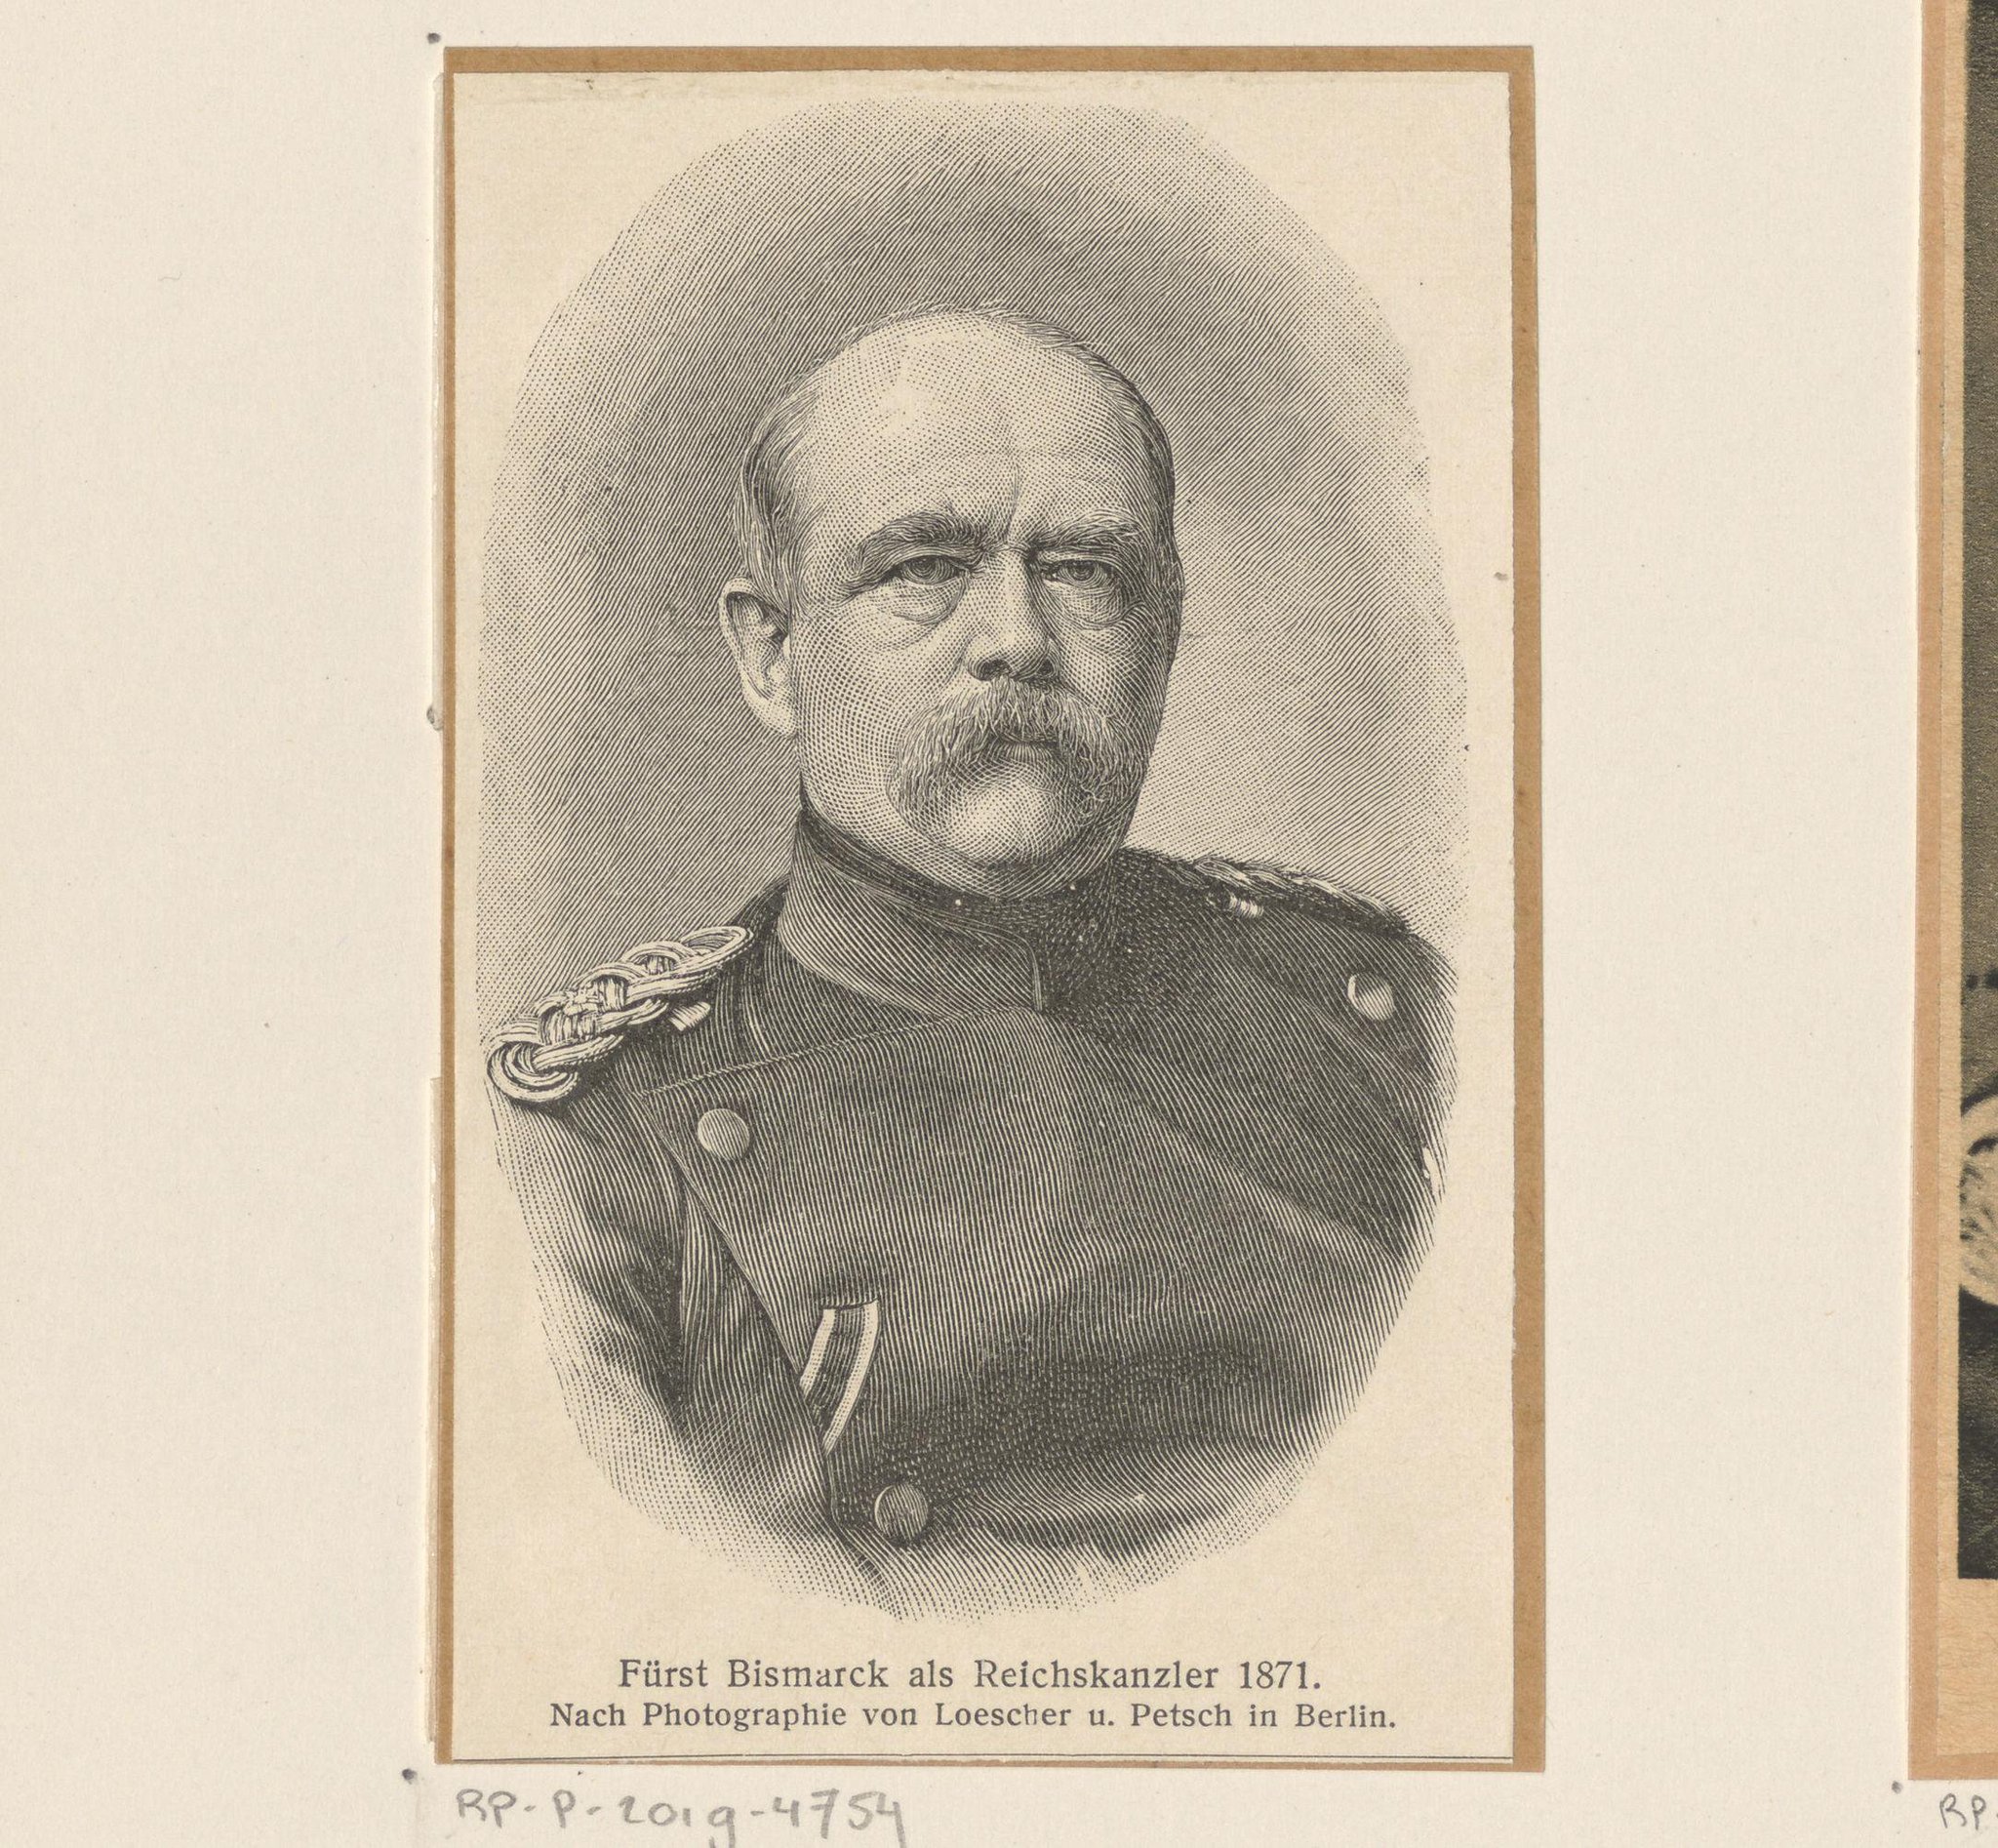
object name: book illustration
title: Portret van Otto von Bismarck op 56-jarige leeftijd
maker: Anonymous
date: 1908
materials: paper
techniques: letterpress printing, engraving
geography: leipzig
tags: historical persons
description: Prent uit: Meyers Grosses Konversations-Lexikon. Ein Nachschlagwerk des allgemeinen Wissens. Leipzig en Wenen: Bibliographisches Institut, 1908, dl. 2.